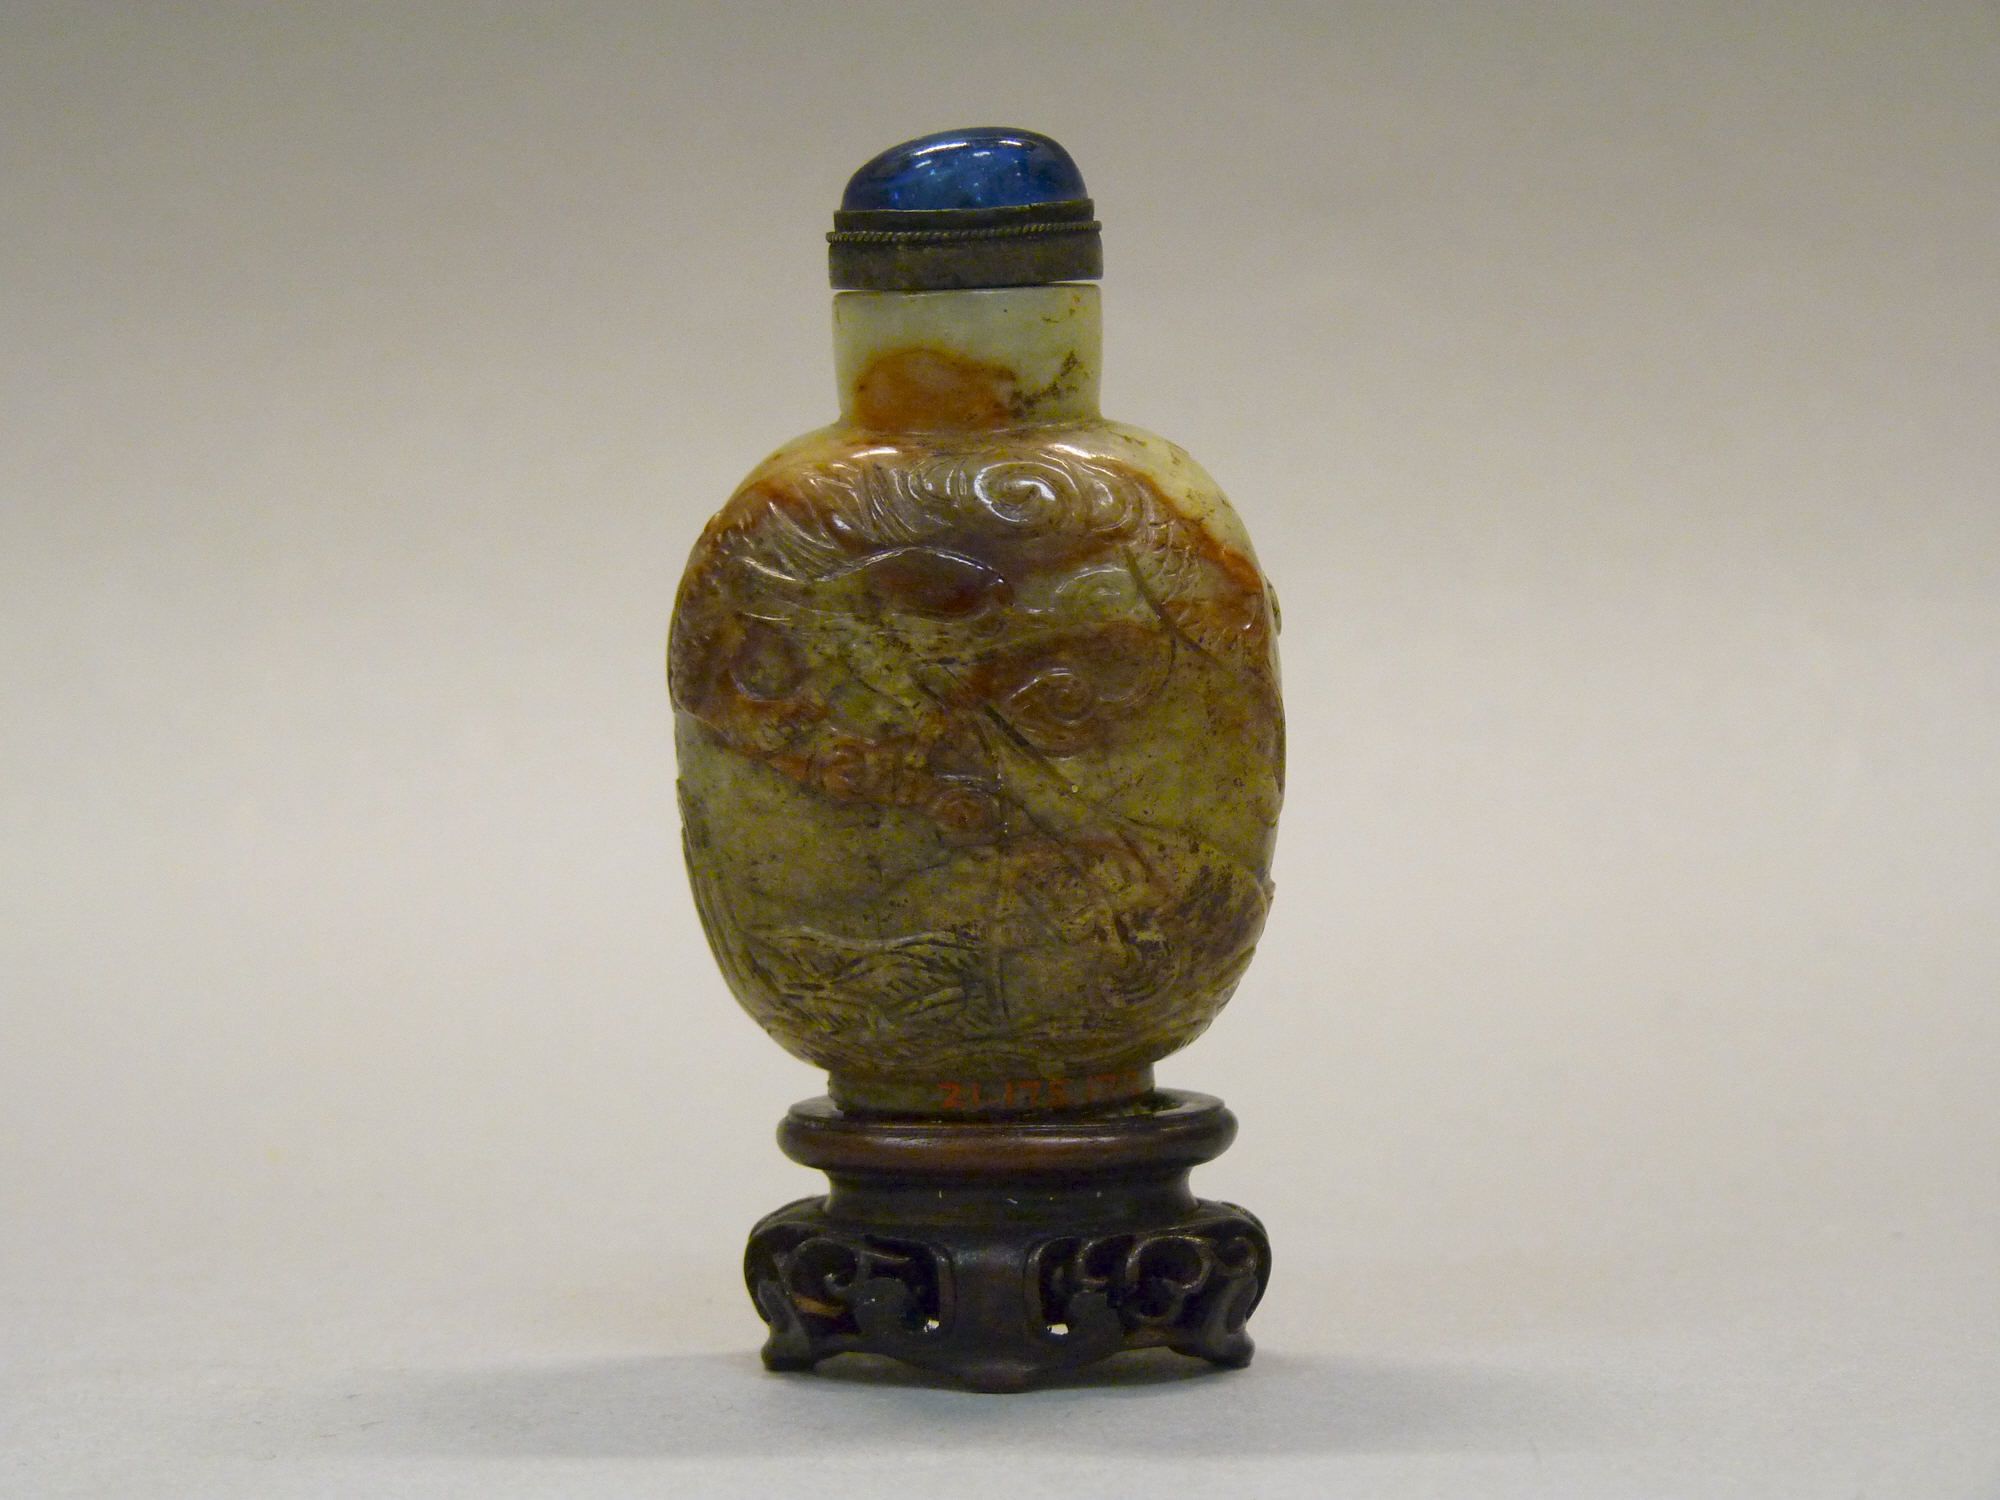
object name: snuff bottle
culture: chinese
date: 1736-1795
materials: glass, jade